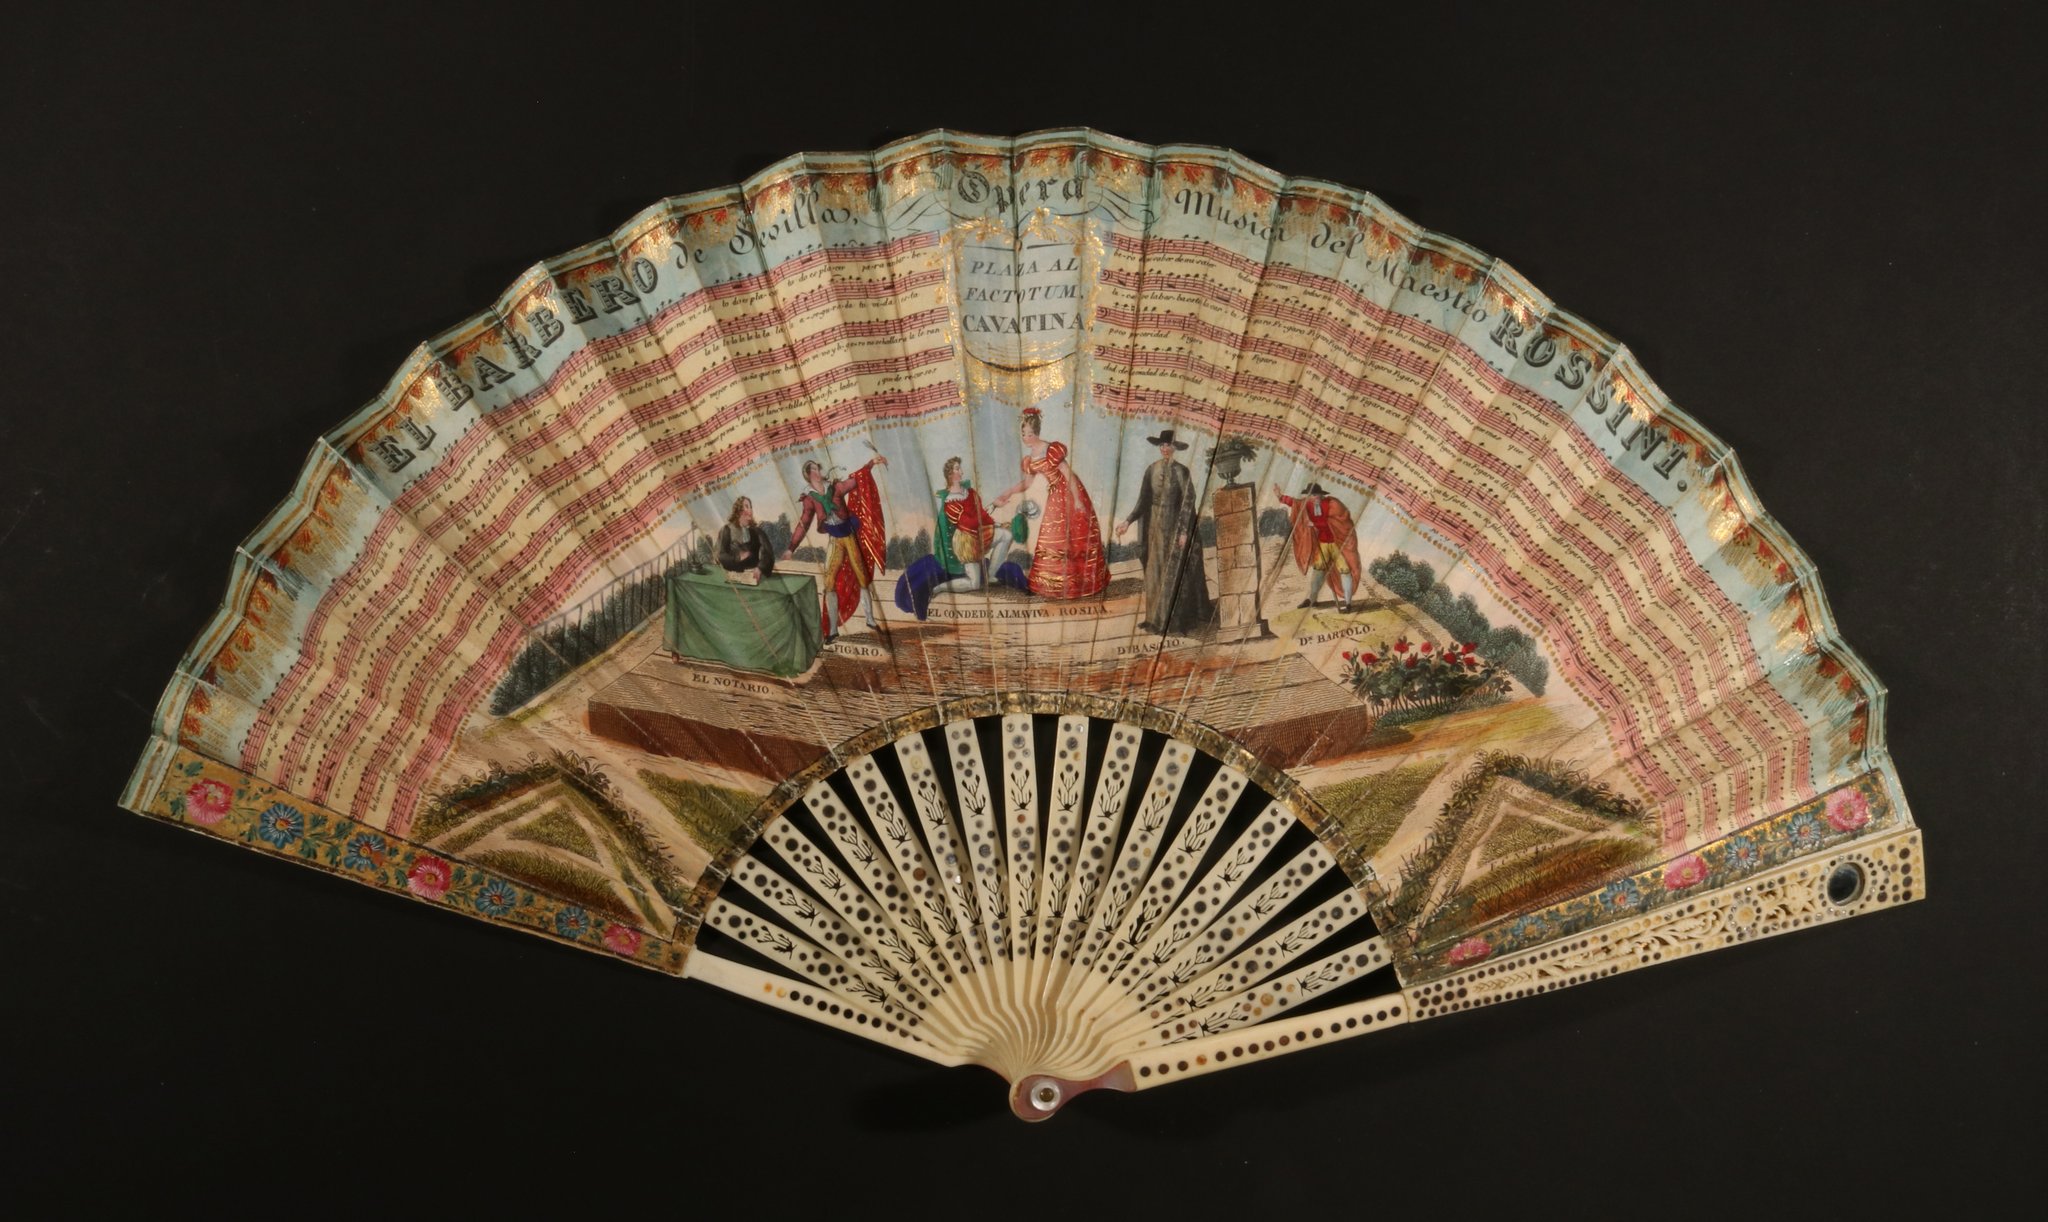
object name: fan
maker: fernando coustellier and co.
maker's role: maker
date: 1818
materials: ivory, paper, parchment, silver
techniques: etching, painting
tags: men,women